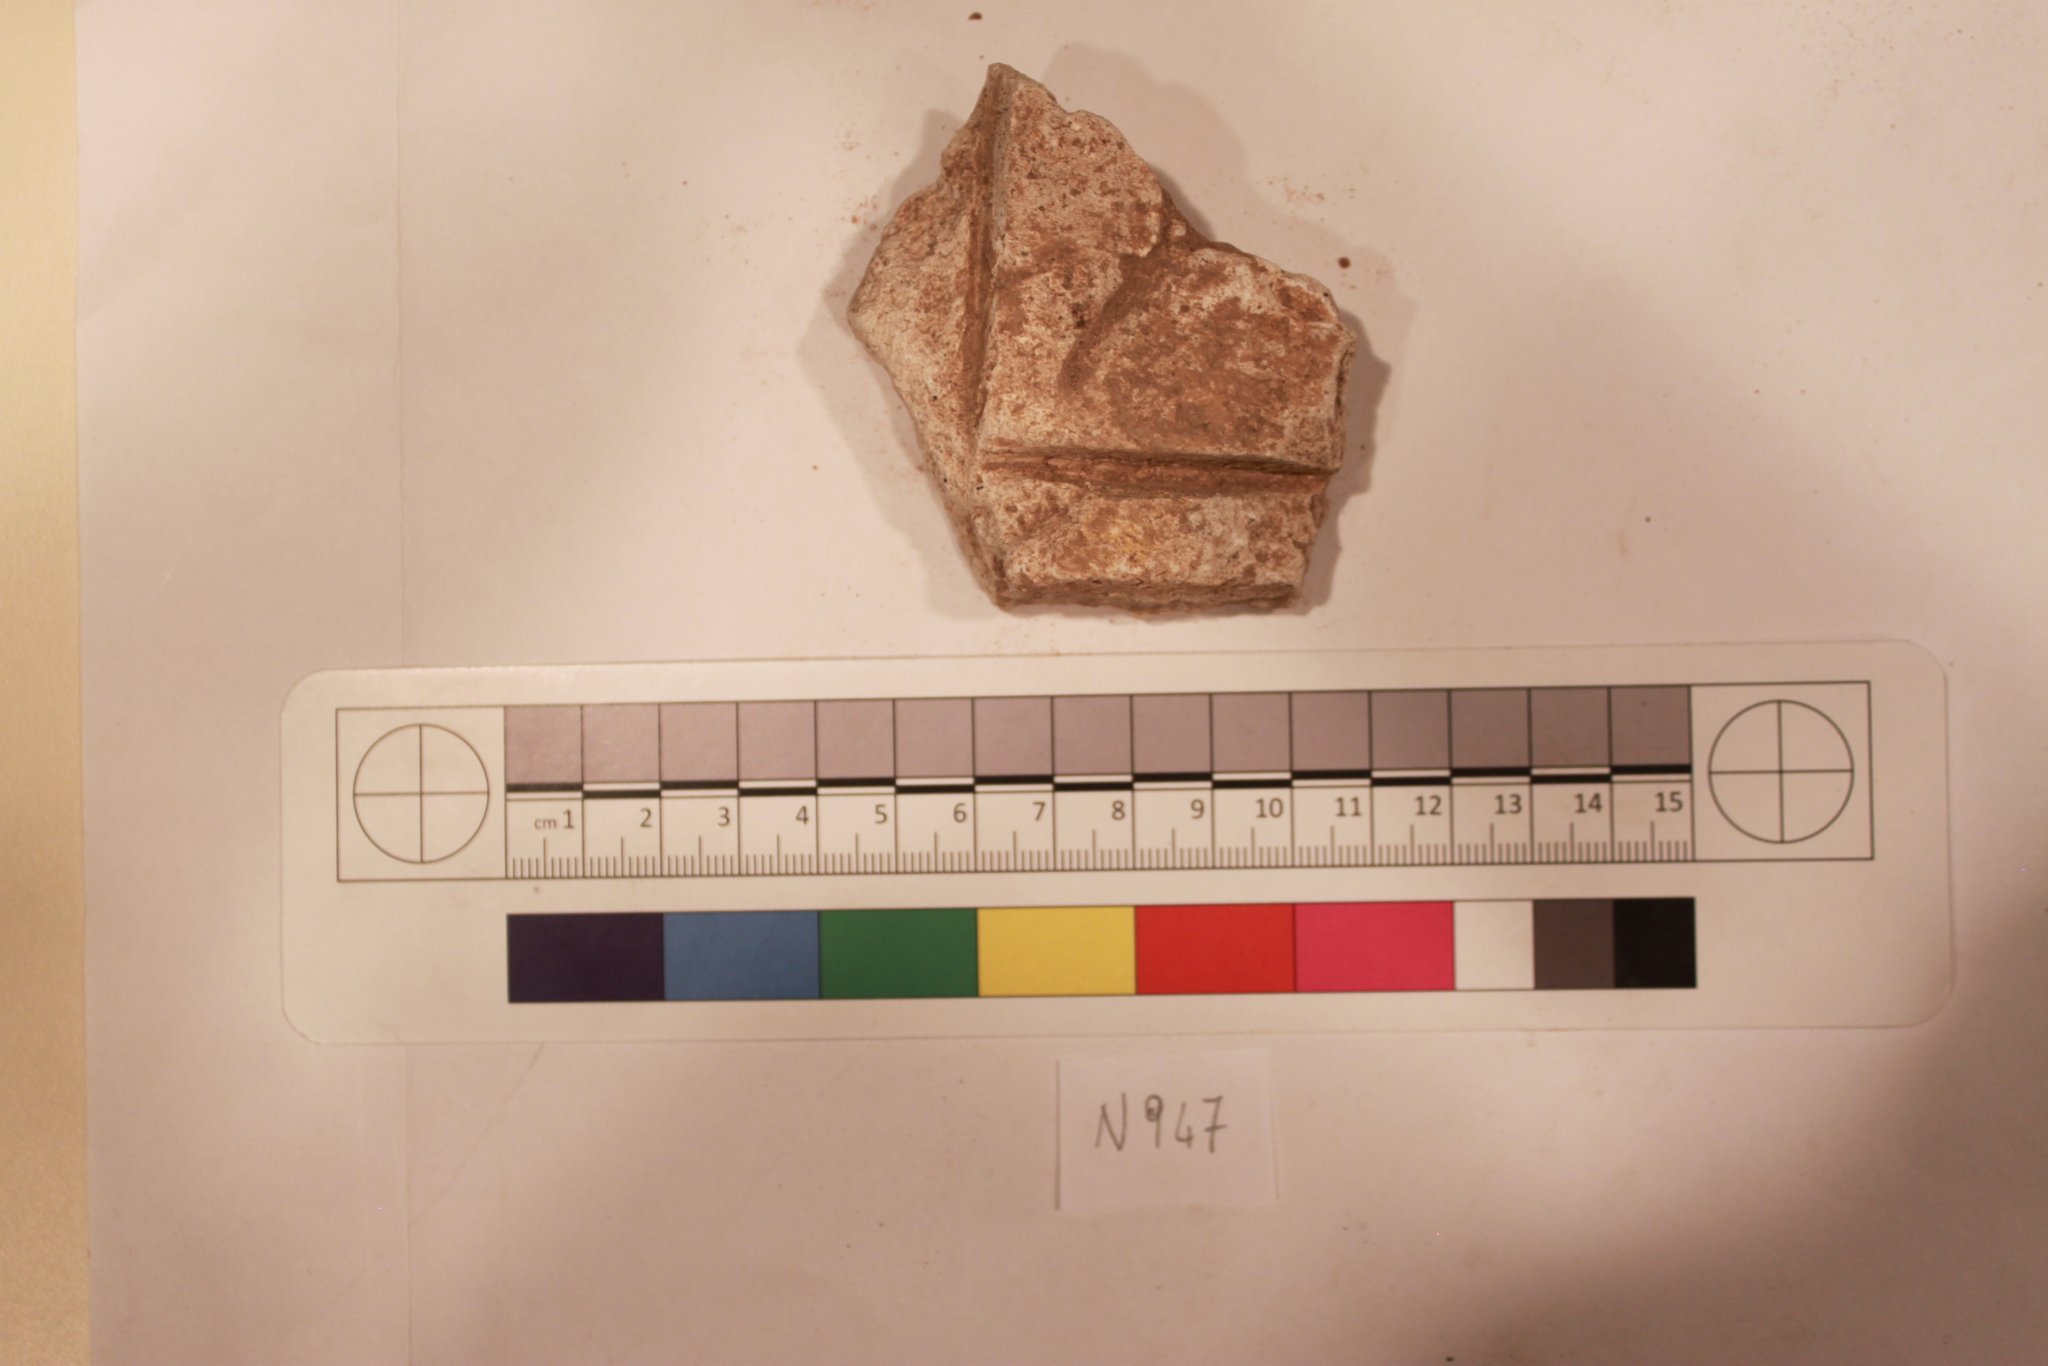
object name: fragment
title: Stucco Fragment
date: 701-1200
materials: plaster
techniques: carving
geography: iran